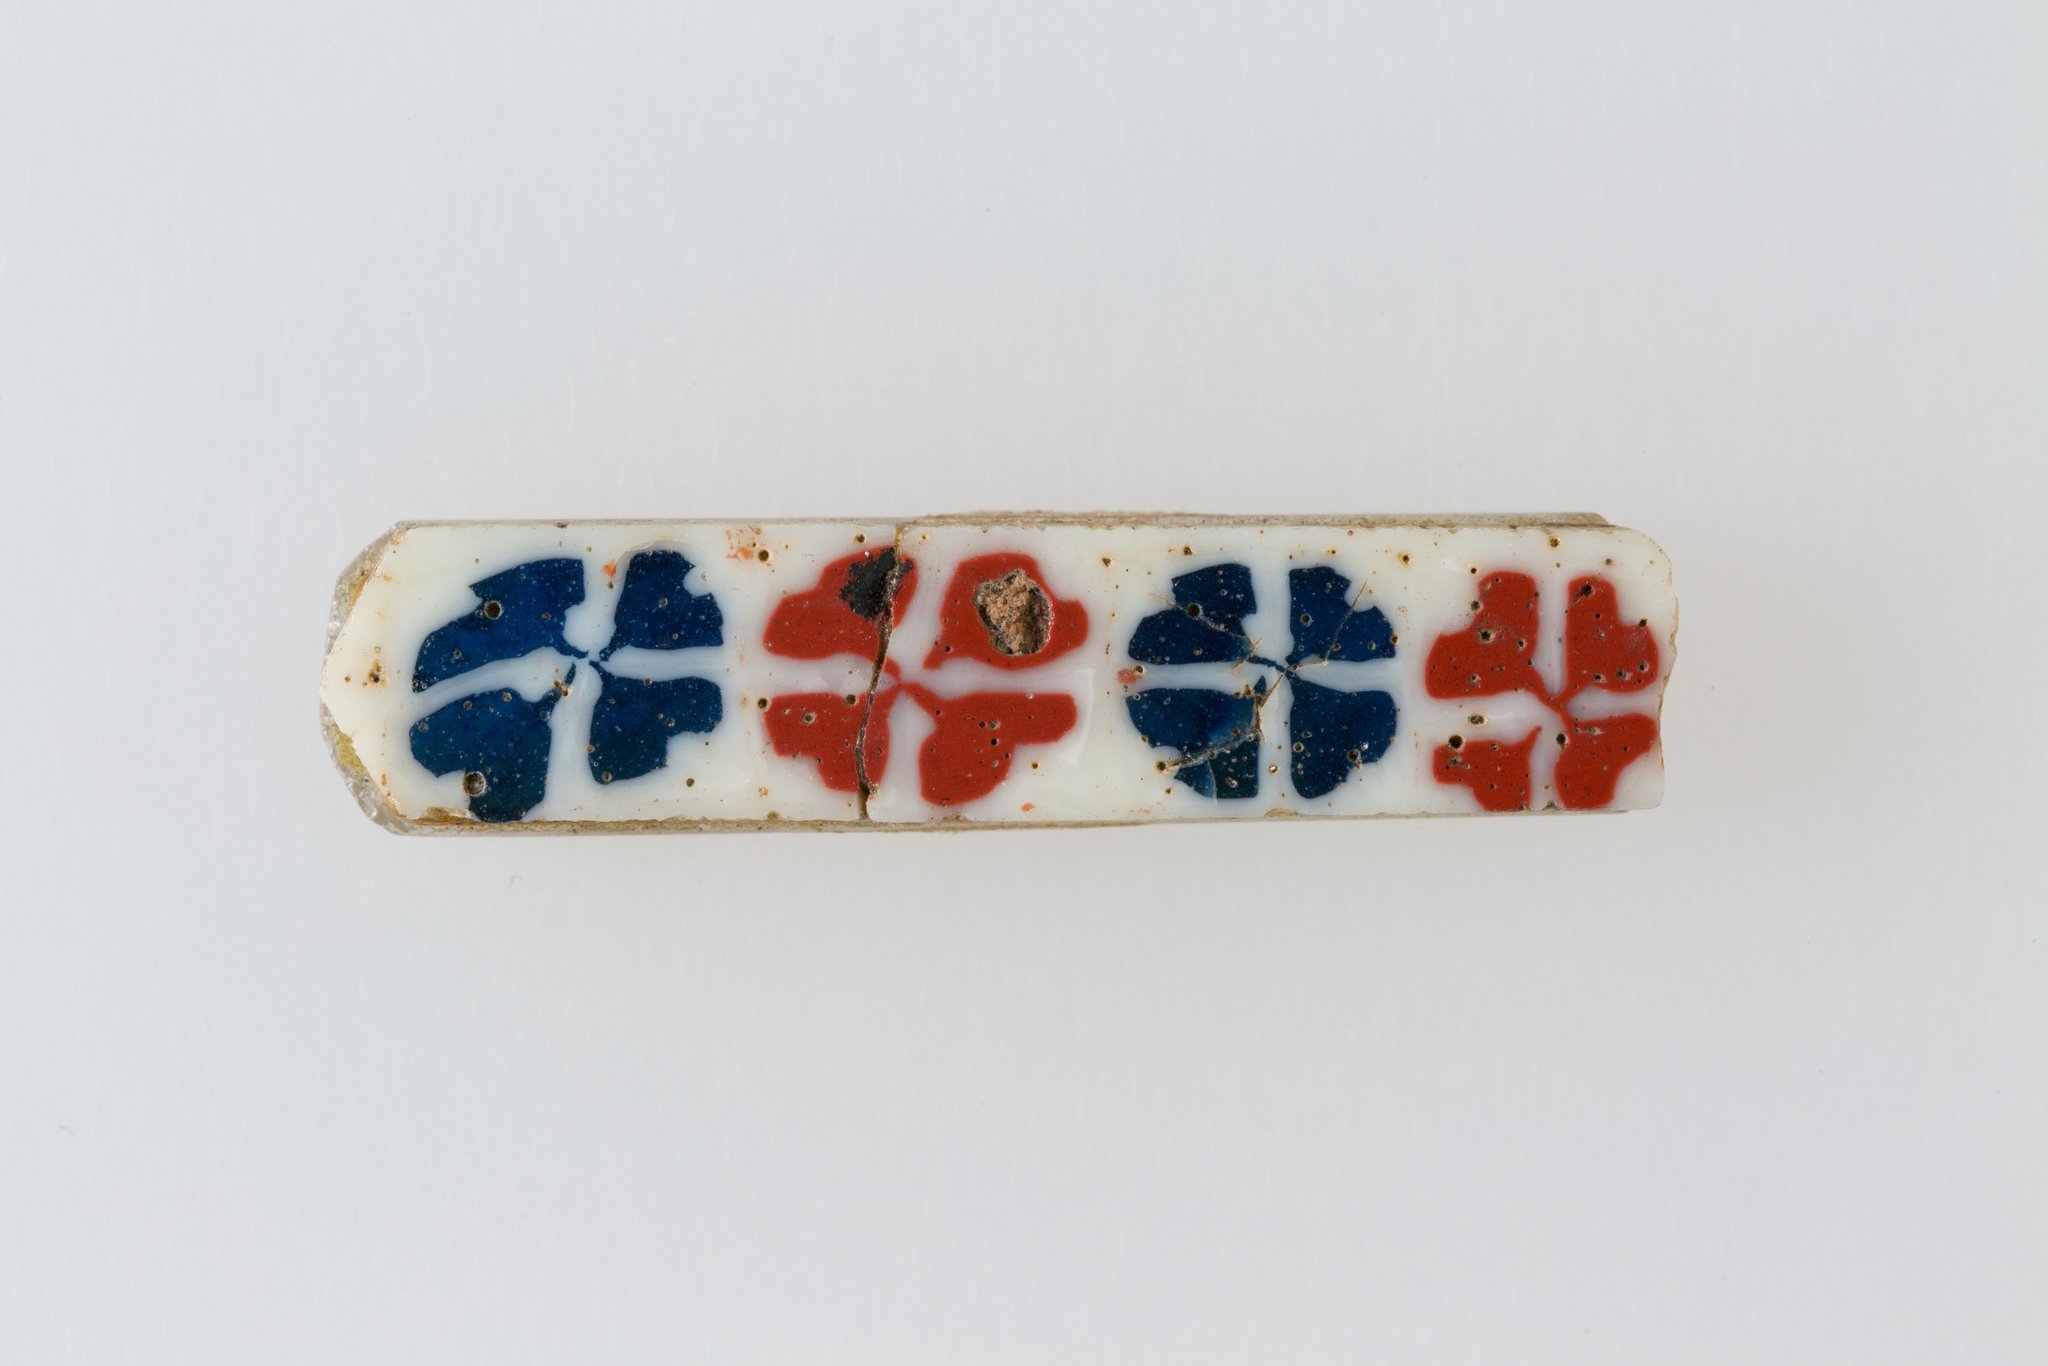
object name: inlay, rosette row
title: Inlay, row of rosettes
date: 200 BCE-100 CE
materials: glass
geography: egypt